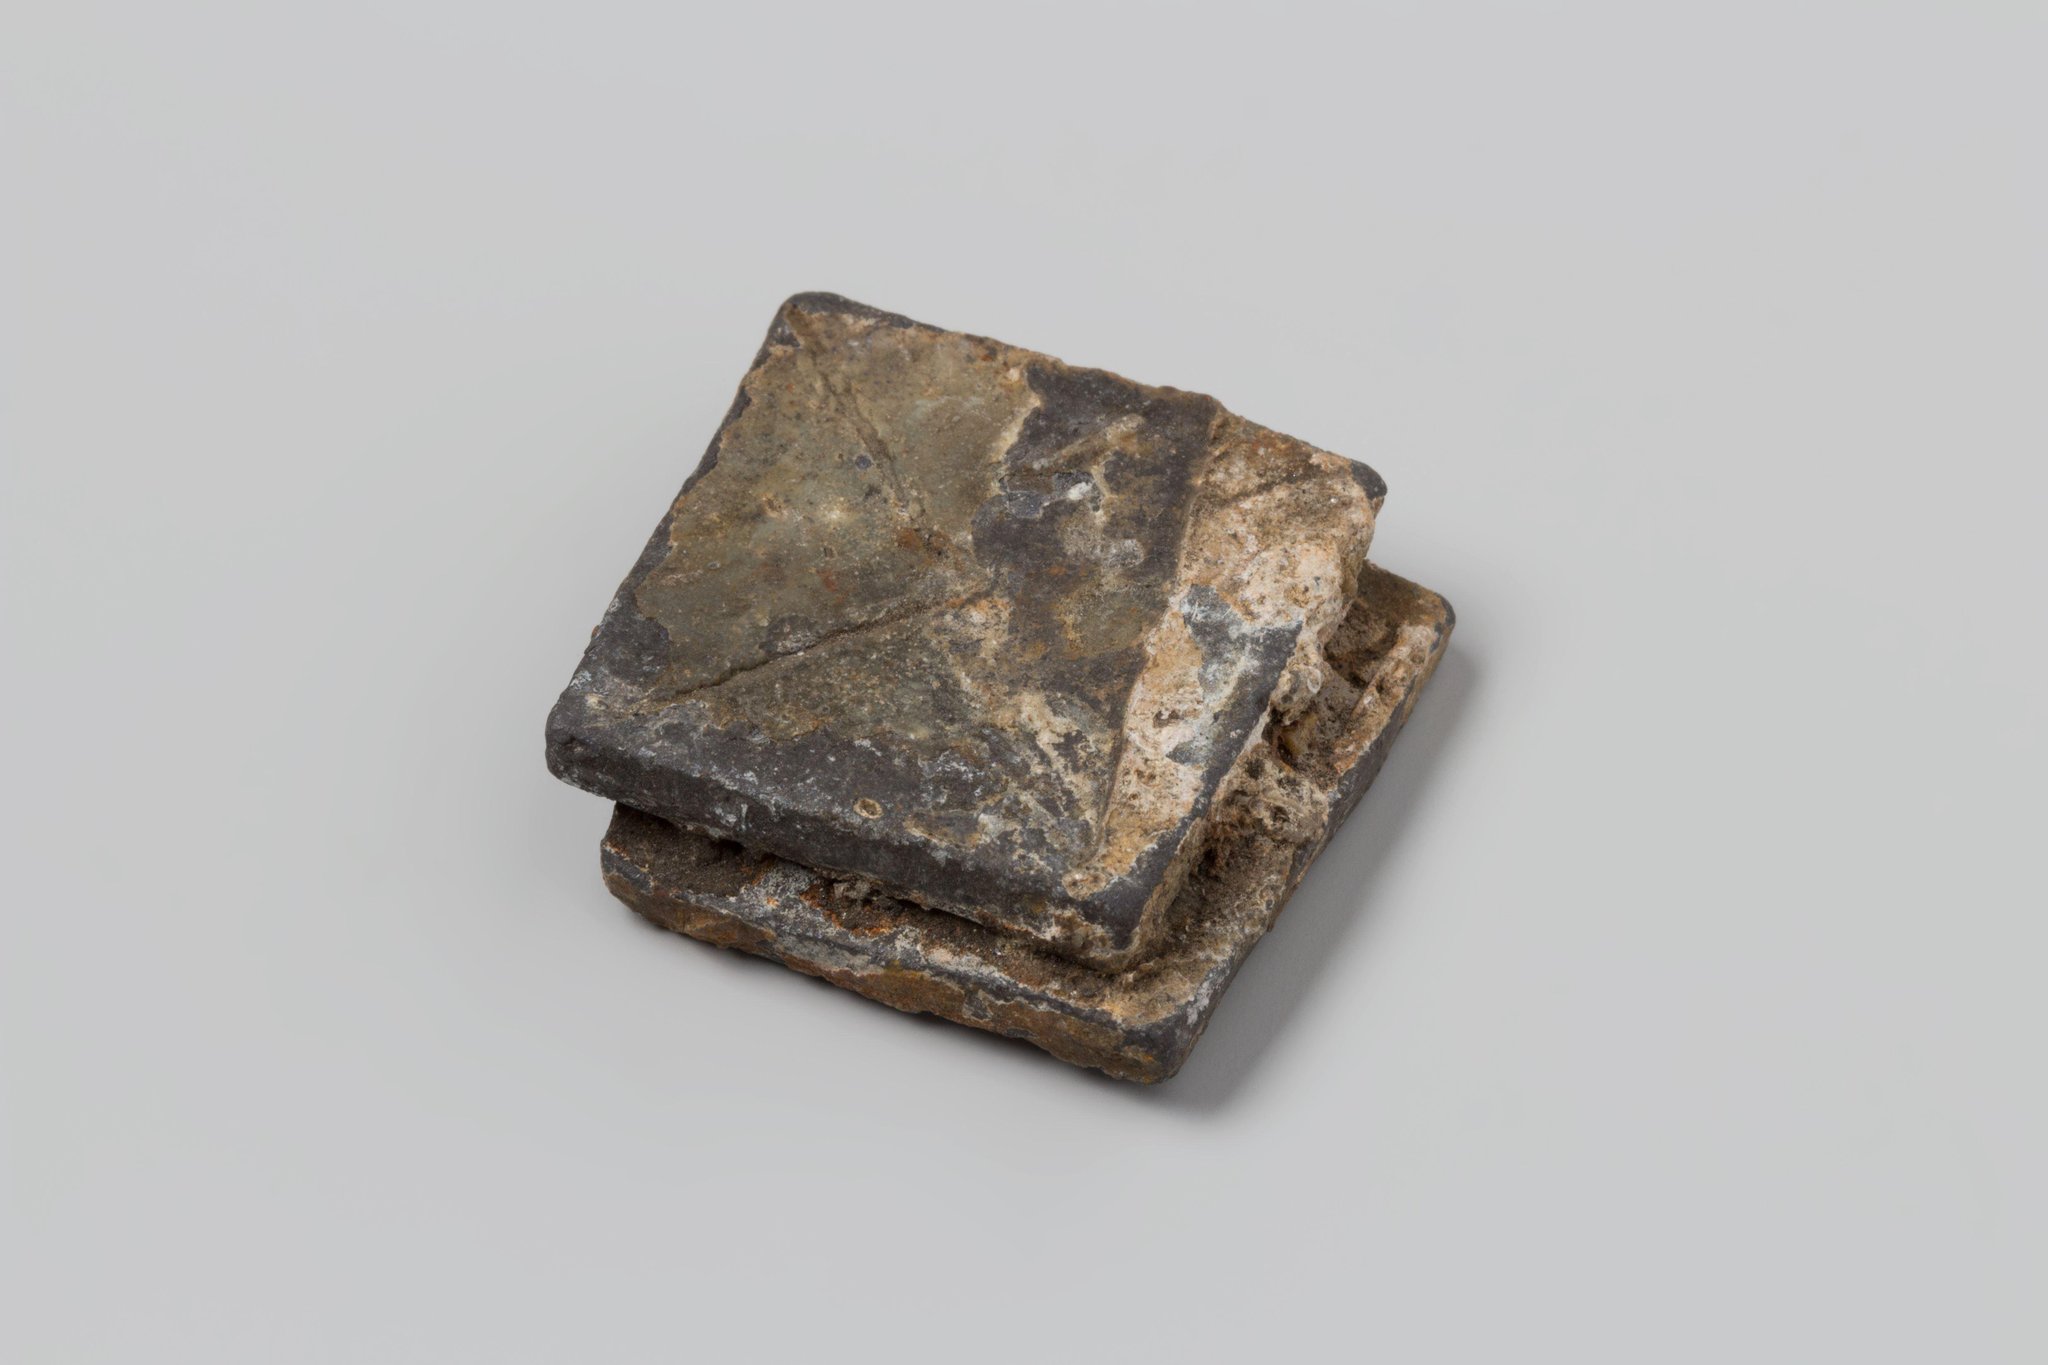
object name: gaming counter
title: Speelpenning uit het wrak van de Oost-Indiëvaarder Hollandia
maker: Anonymous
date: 1700-1743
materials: lead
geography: netherlands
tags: verenigde oostindische compagnie, hollandia (schip), annet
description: Rectangular, square, flat, engraved diagonal cross on one side, game token. Zit vast aan NG-1979-331-H.